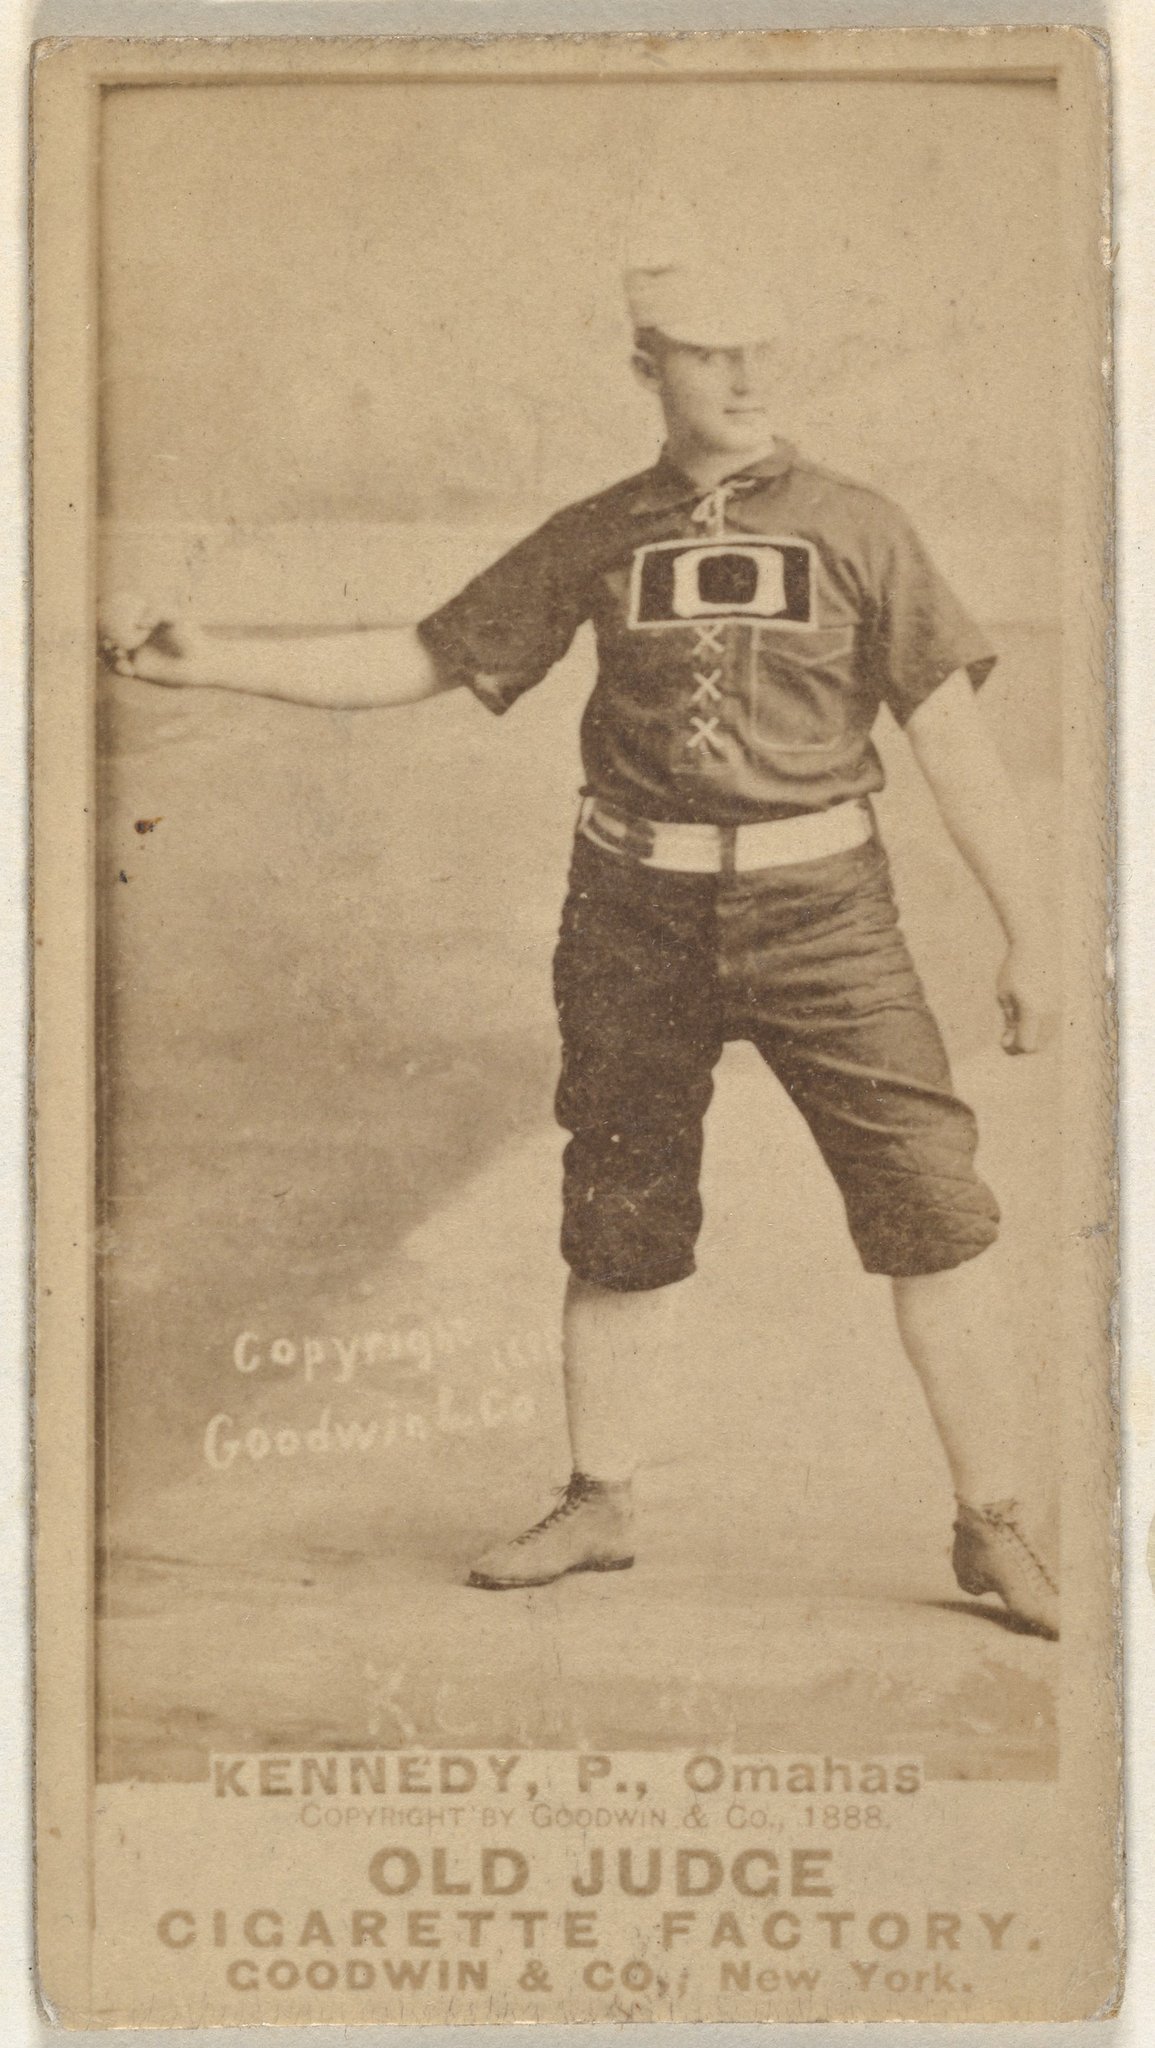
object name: baseball card, photograph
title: Theodore A. "Ted" Kennedy, Pitcher, Omaha Omahogs/ Lambs, from the Old Judge series (N172) for Old Judge Cigarettes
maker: goodwin & company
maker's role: publisher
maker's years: 1850-1950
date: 1888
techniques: albumen silver print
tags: men,portraits,baseball,athletes